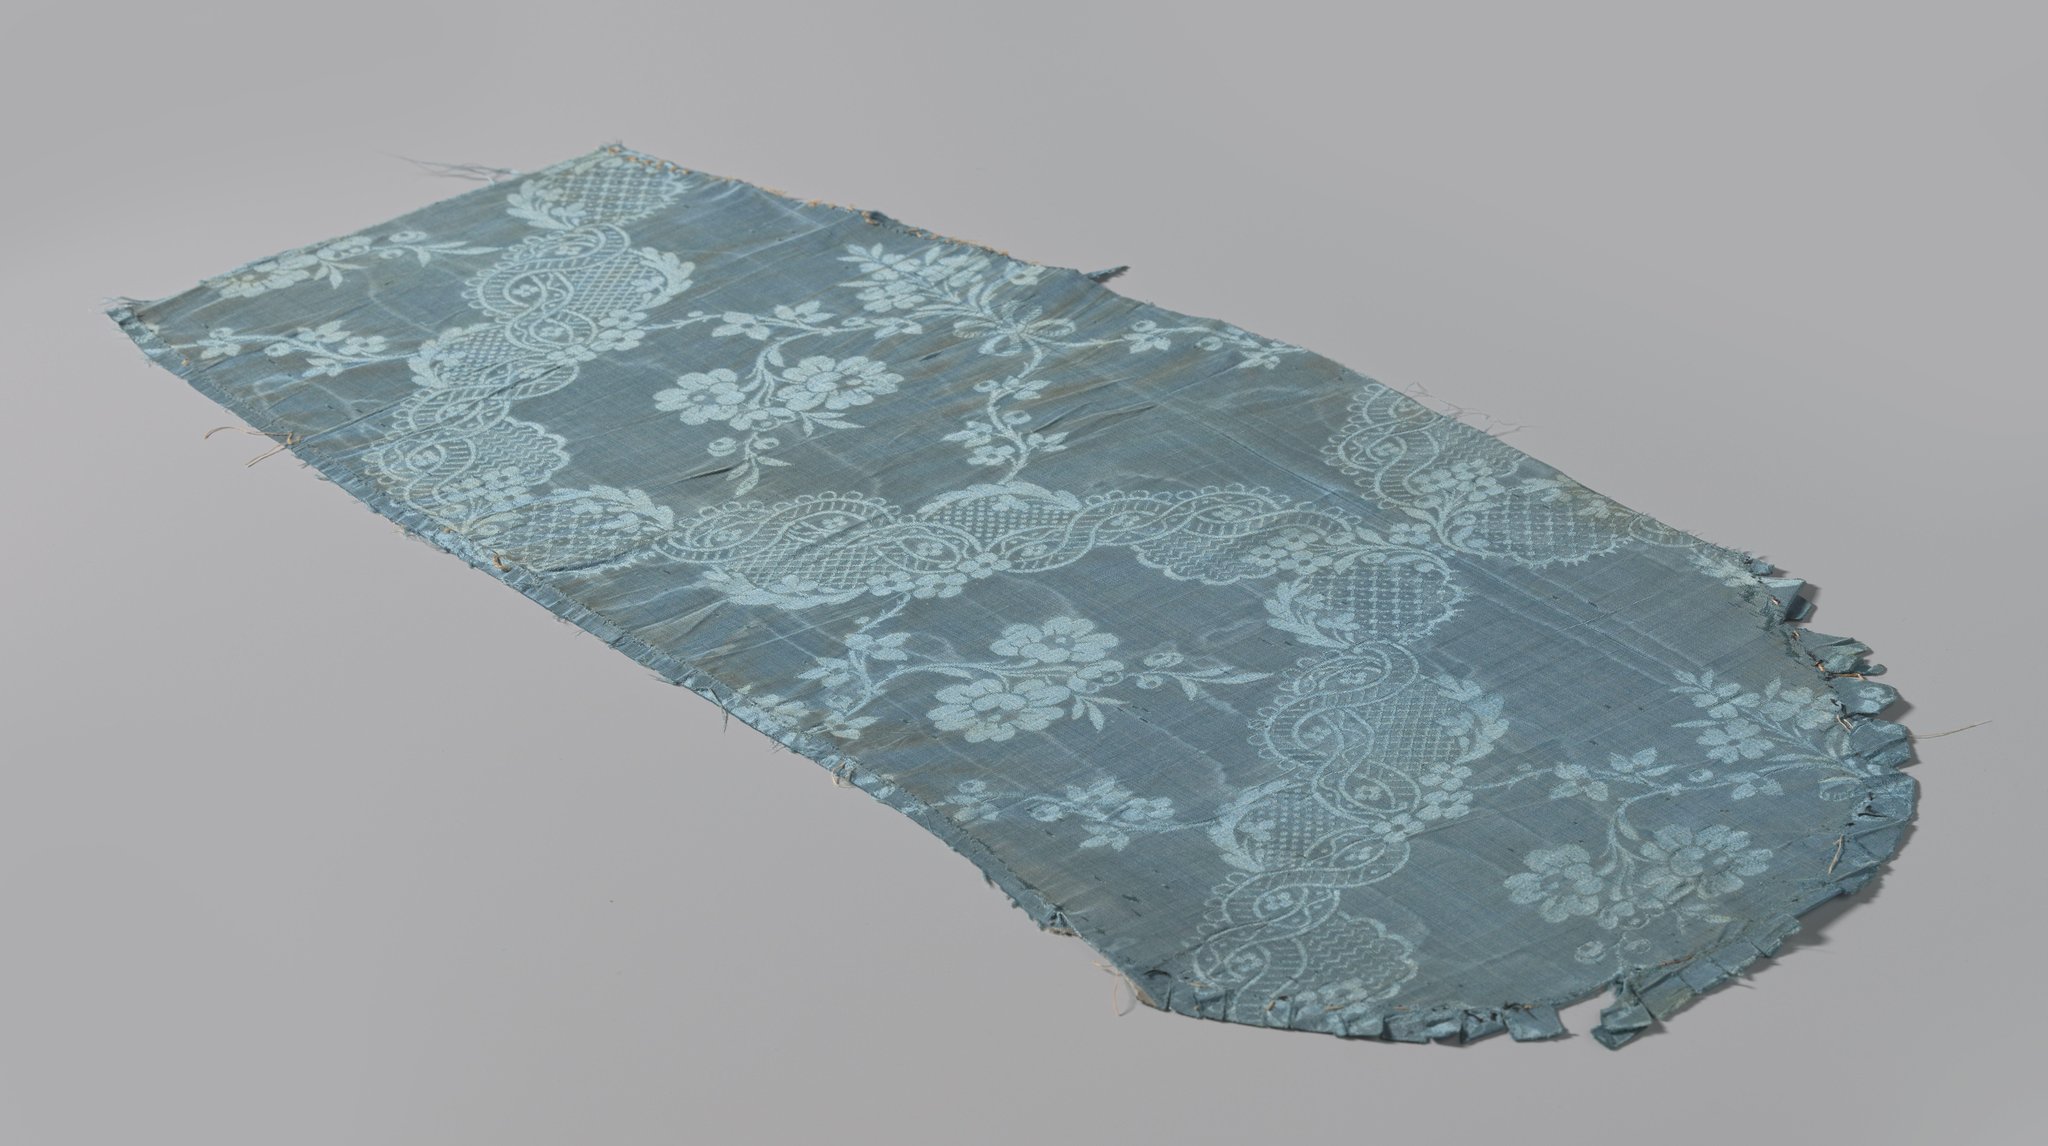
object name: zijdedamast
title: Fragmenten zijdedamast, blauw, met patroon van bloemen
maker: Anonymous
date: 1760-1770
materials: silk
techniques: damask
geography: france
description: Fragmenten zijdedamast, blauw, met patroon van bloemen. In een brief uit 1976 van de heer C. Burgers, gevonden in de losse doucmentatie wordt over vier fragmenten gesproken.